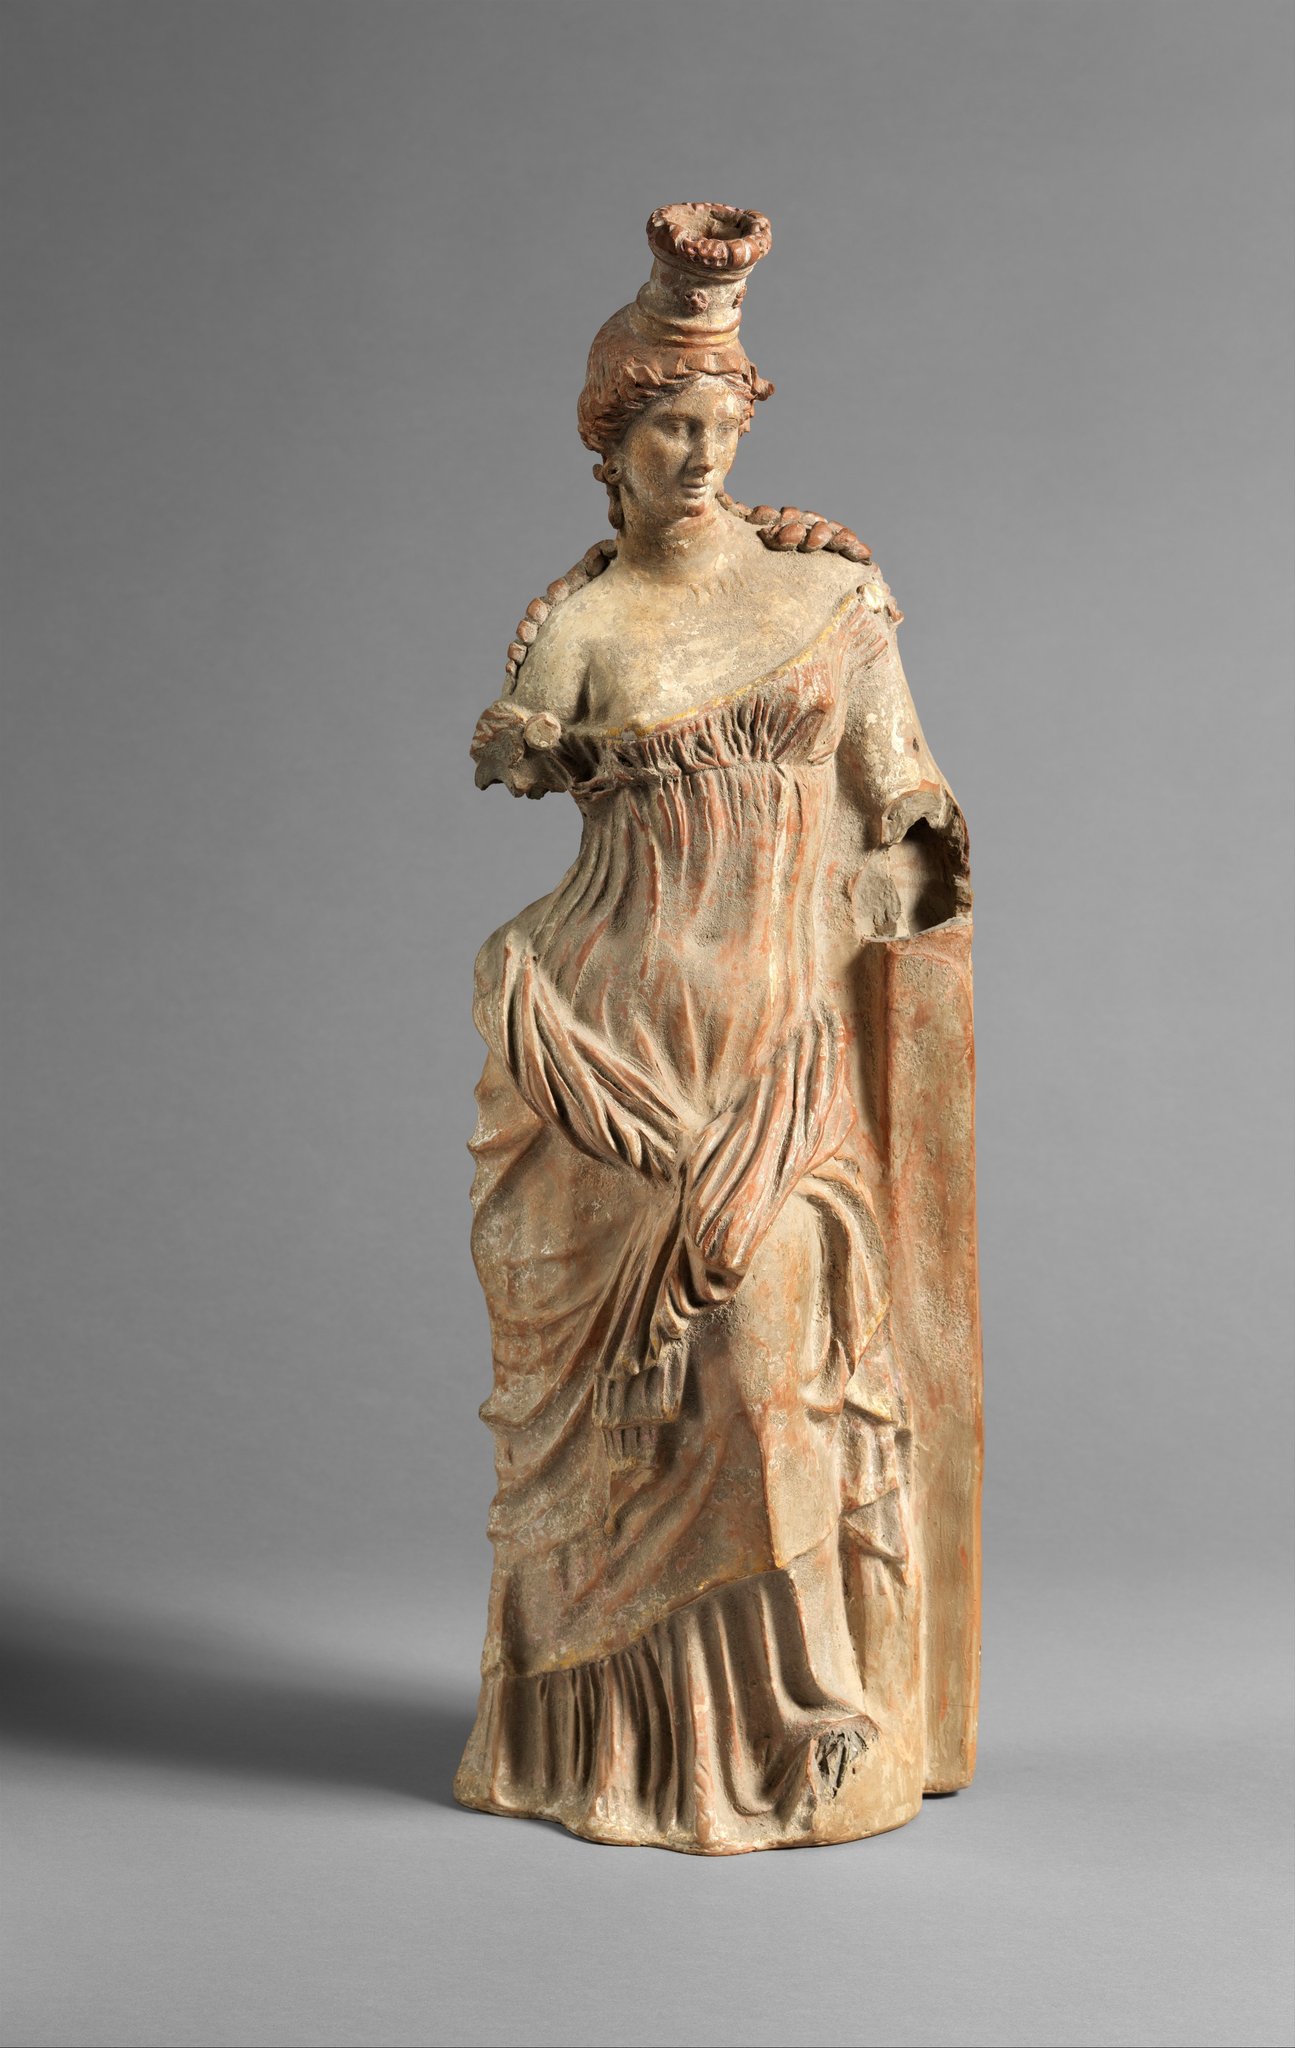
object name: statuette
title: Terracotta statuette of a goddess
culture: greek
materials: terracotta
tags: women,goddess